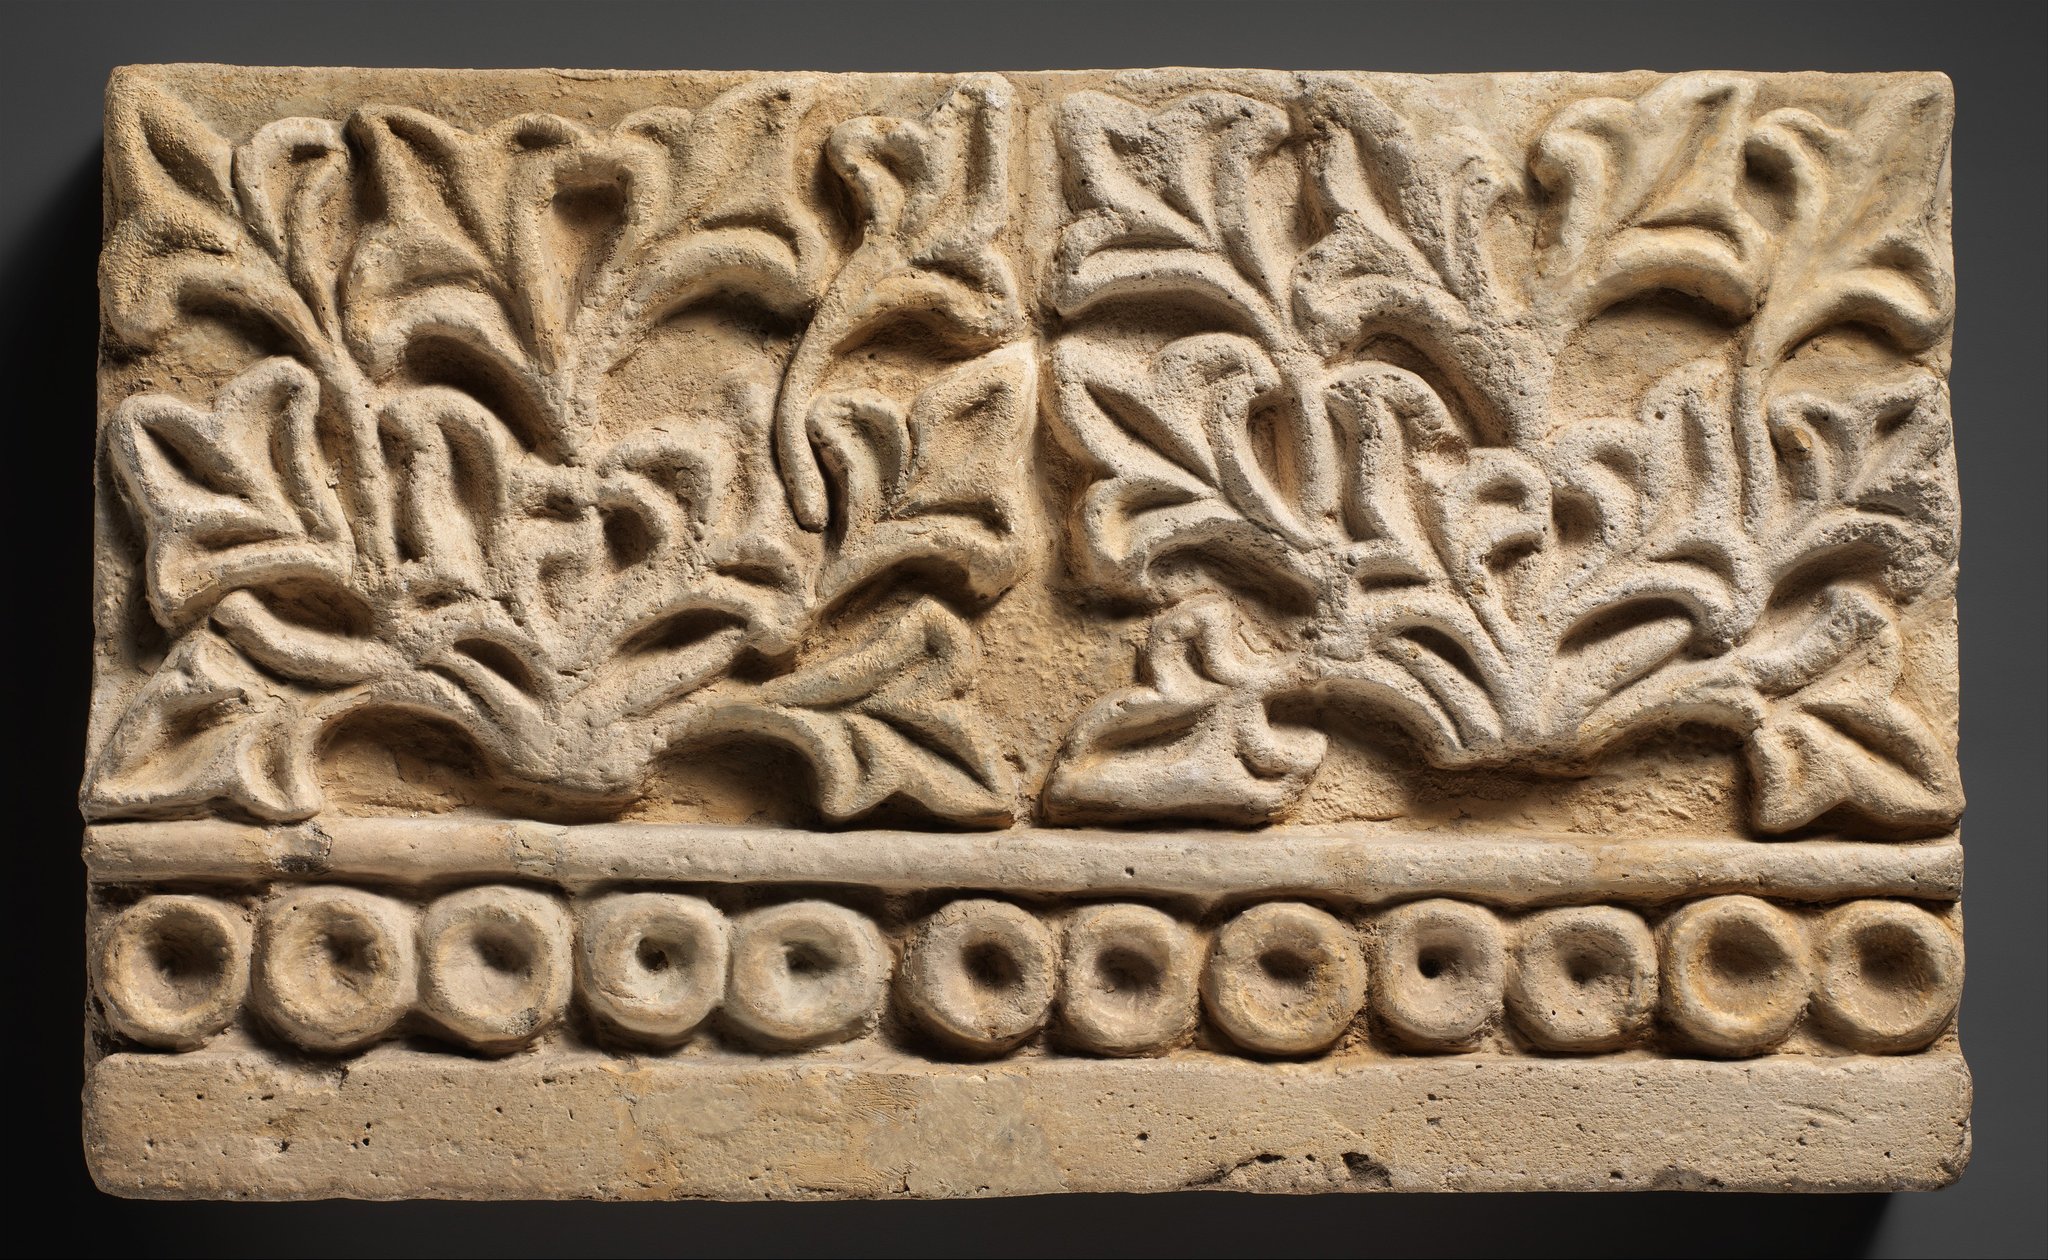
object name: relief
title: Wall decoration with vegetal design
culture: sasanian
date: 501-600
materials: plaster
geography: mesopotamia